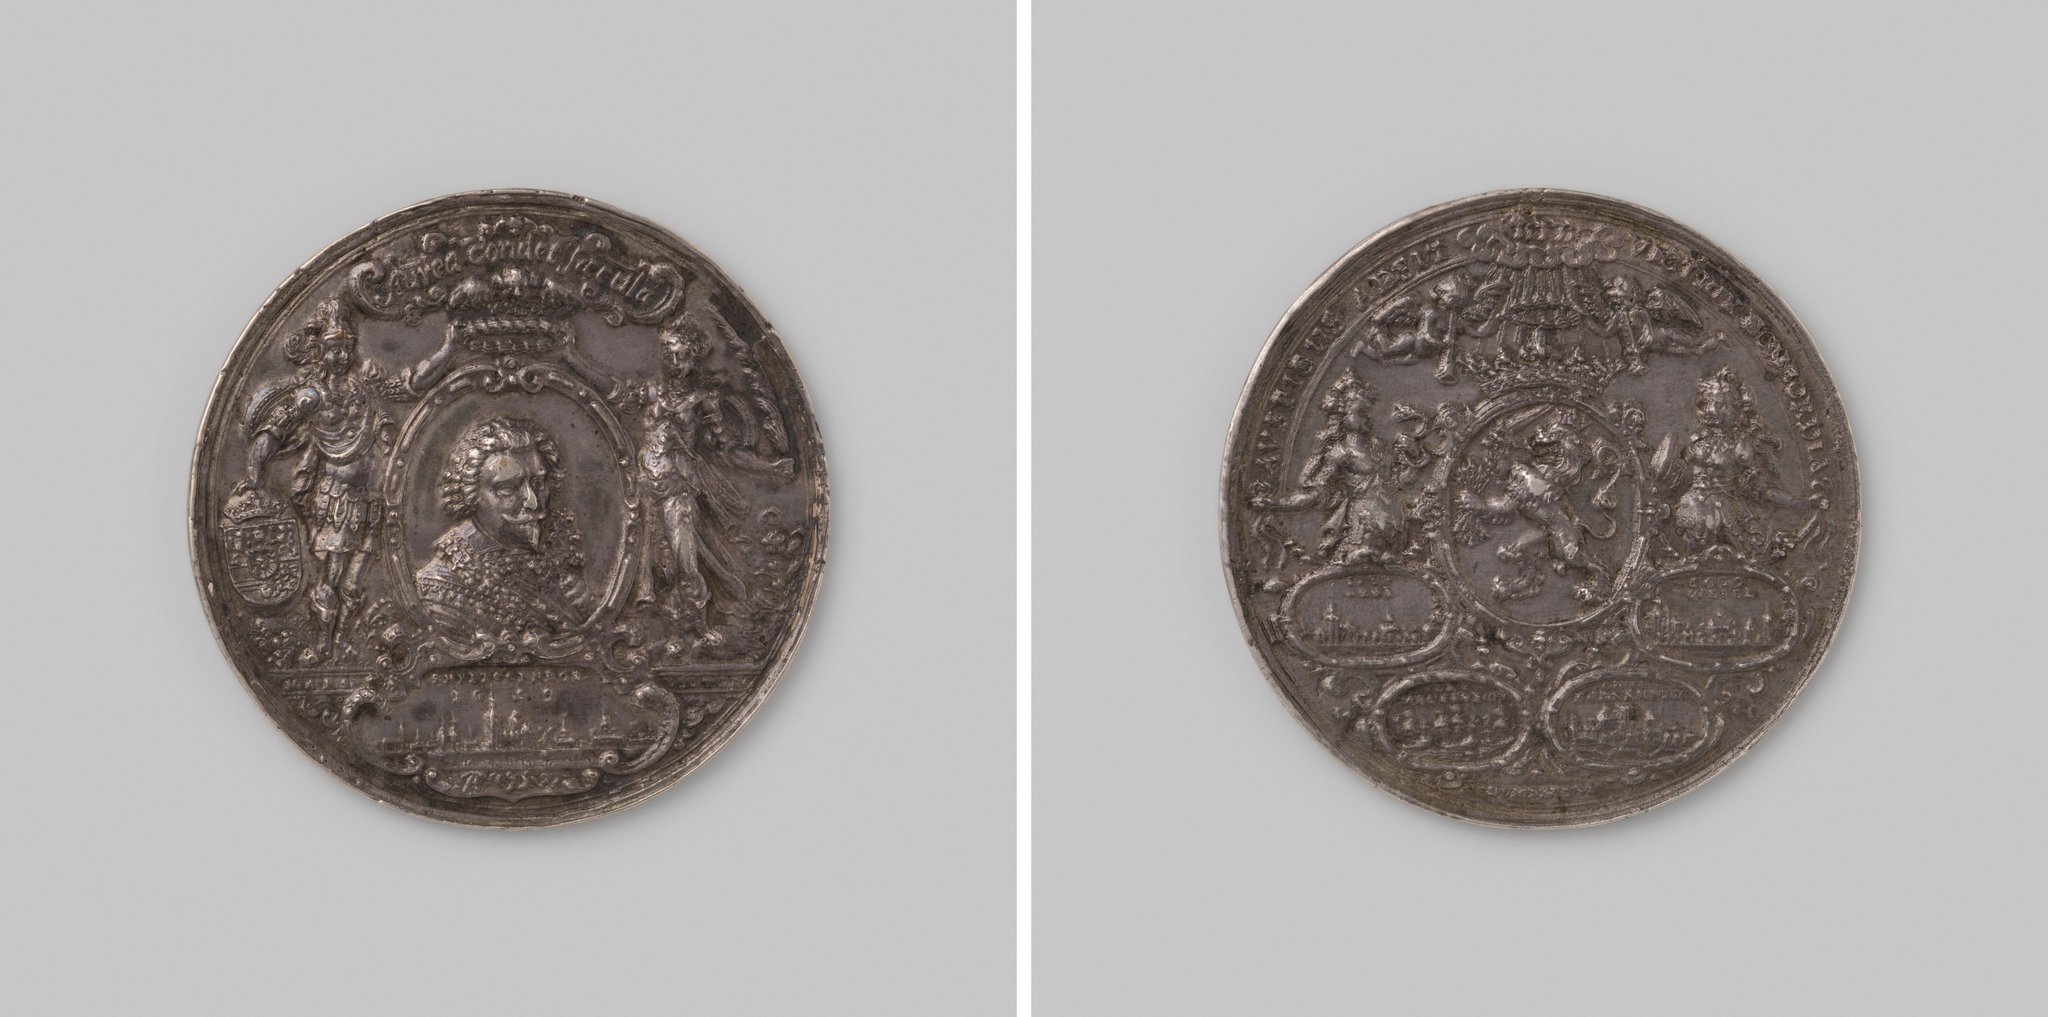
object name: history medal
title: Overwinningen van stadhouder Frederik Hendrik, 1627-1630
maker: anthonis pietersz. van der willigen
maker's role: draughtsman, print maker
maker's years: 1591-1640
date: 1631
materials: silver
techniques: casting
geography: netherlands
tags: delfshaven, delft, the hague, frederick henry (prince of orange), den bosch, capture of the spanish treasure fleet